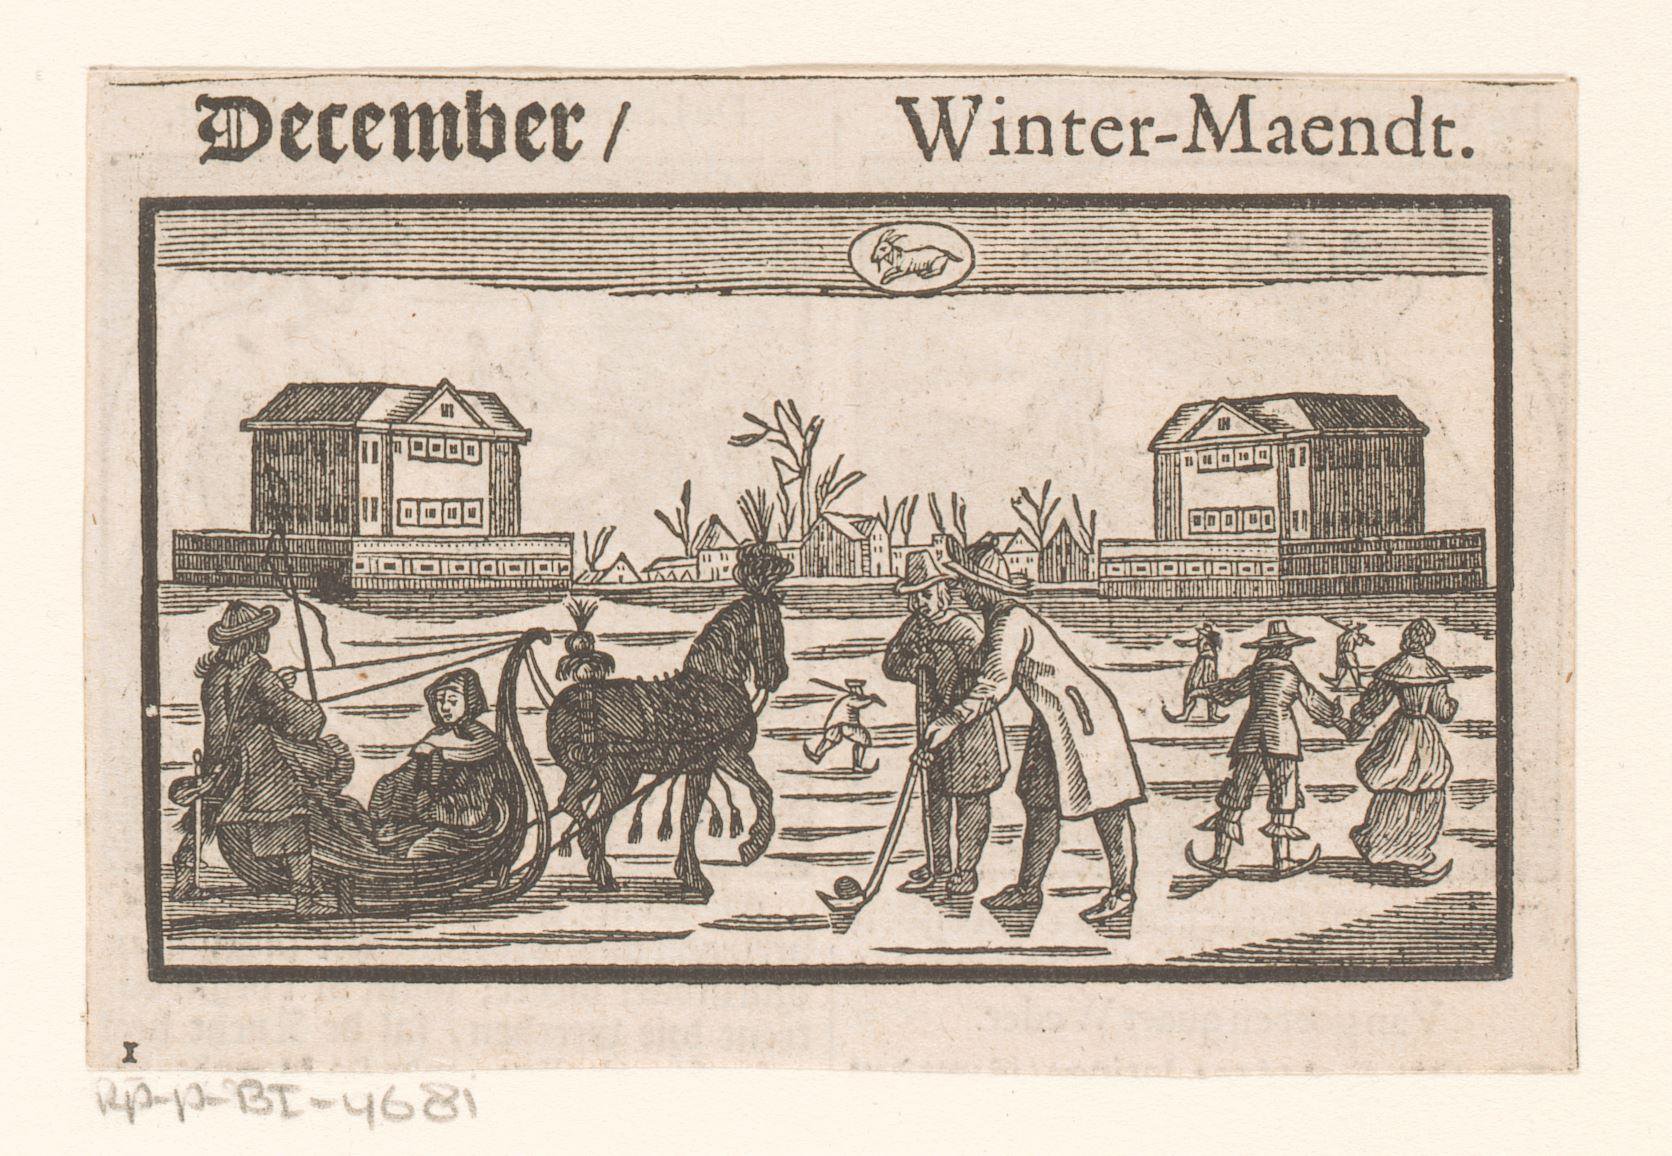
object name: print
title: December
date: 1664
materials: paper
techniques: letterpress printing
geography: amsterdam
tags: horse-sleigh, december and its 'labours' (+ with capricorn (december)), skates (winter sports)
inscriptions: collector's mark: Lugt 240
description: Prent uit: Saeghman, Gillis Joosten. Groote comptoir almanach op't schrickel-iaer. Amsterdam: Gillis Joosten Saeghman, 1664.